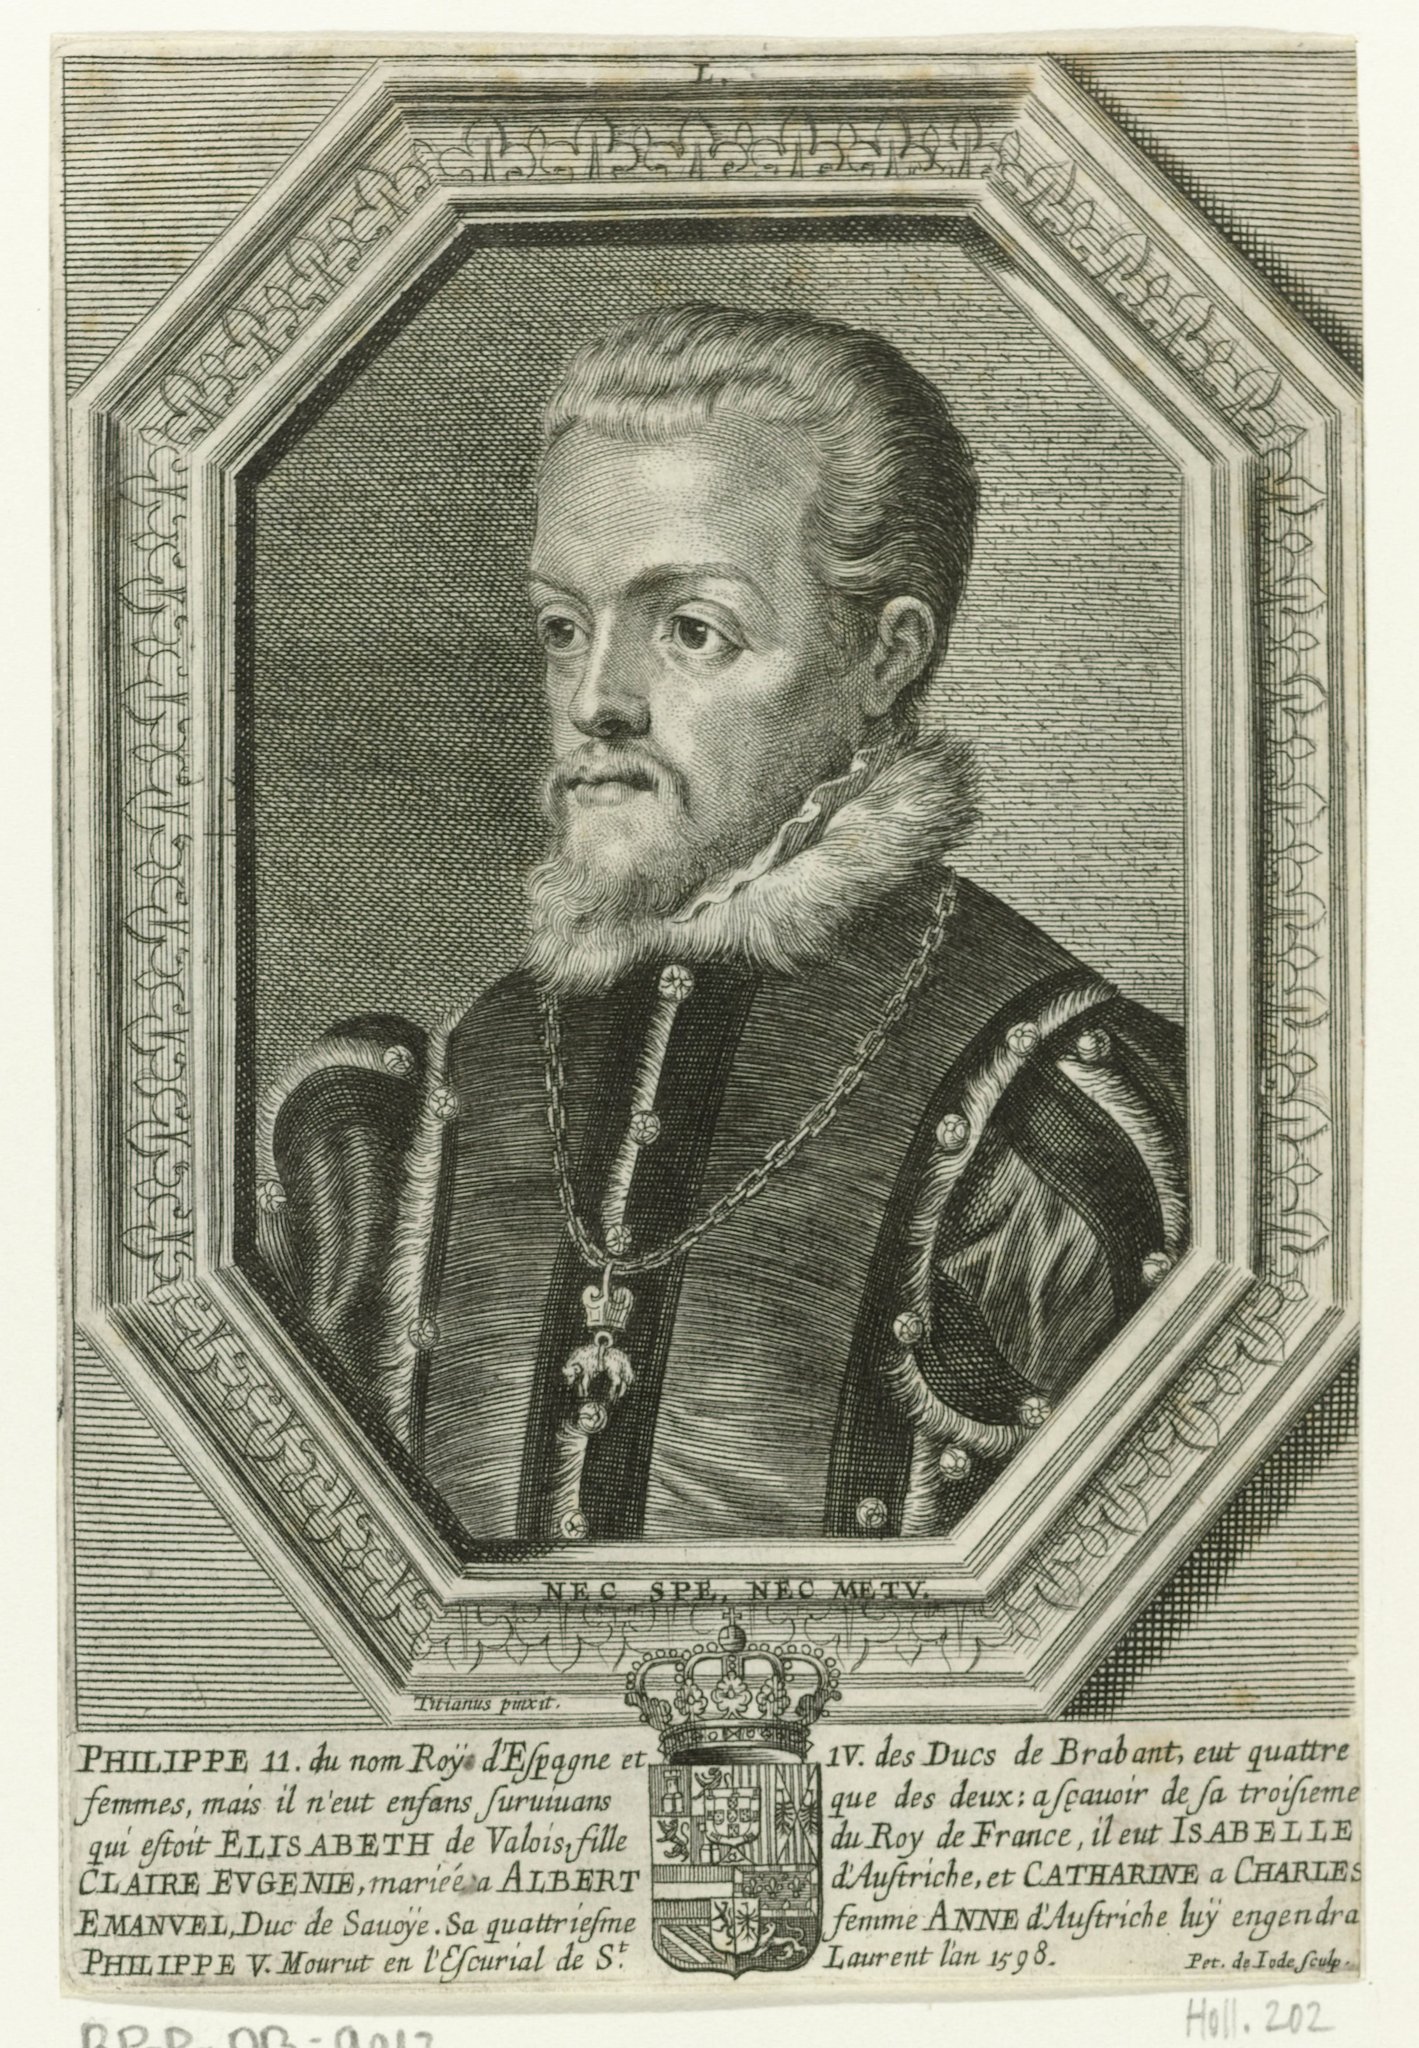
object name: book illustration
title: Portret van Filips II, koning van Spanje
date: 1661-1663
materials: paper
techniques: engraving, etching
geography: antwerp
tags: philip ii of spain, historical persons, knighthood order of the golden fleece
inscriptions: collector's mark: Lugt 240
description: Portret van Filips II, koning van Spanje. Hij draagt een keten met de Orde van het Gulden Vlies. Het portret is gevat in een achthoekige omlijsting met een motto in het Latijn. In de marge het wapenschild van de geportretteerde en een zesregelig onderschrift in het Frans. Prent uit een boek waarin 54 prenten met portretten.